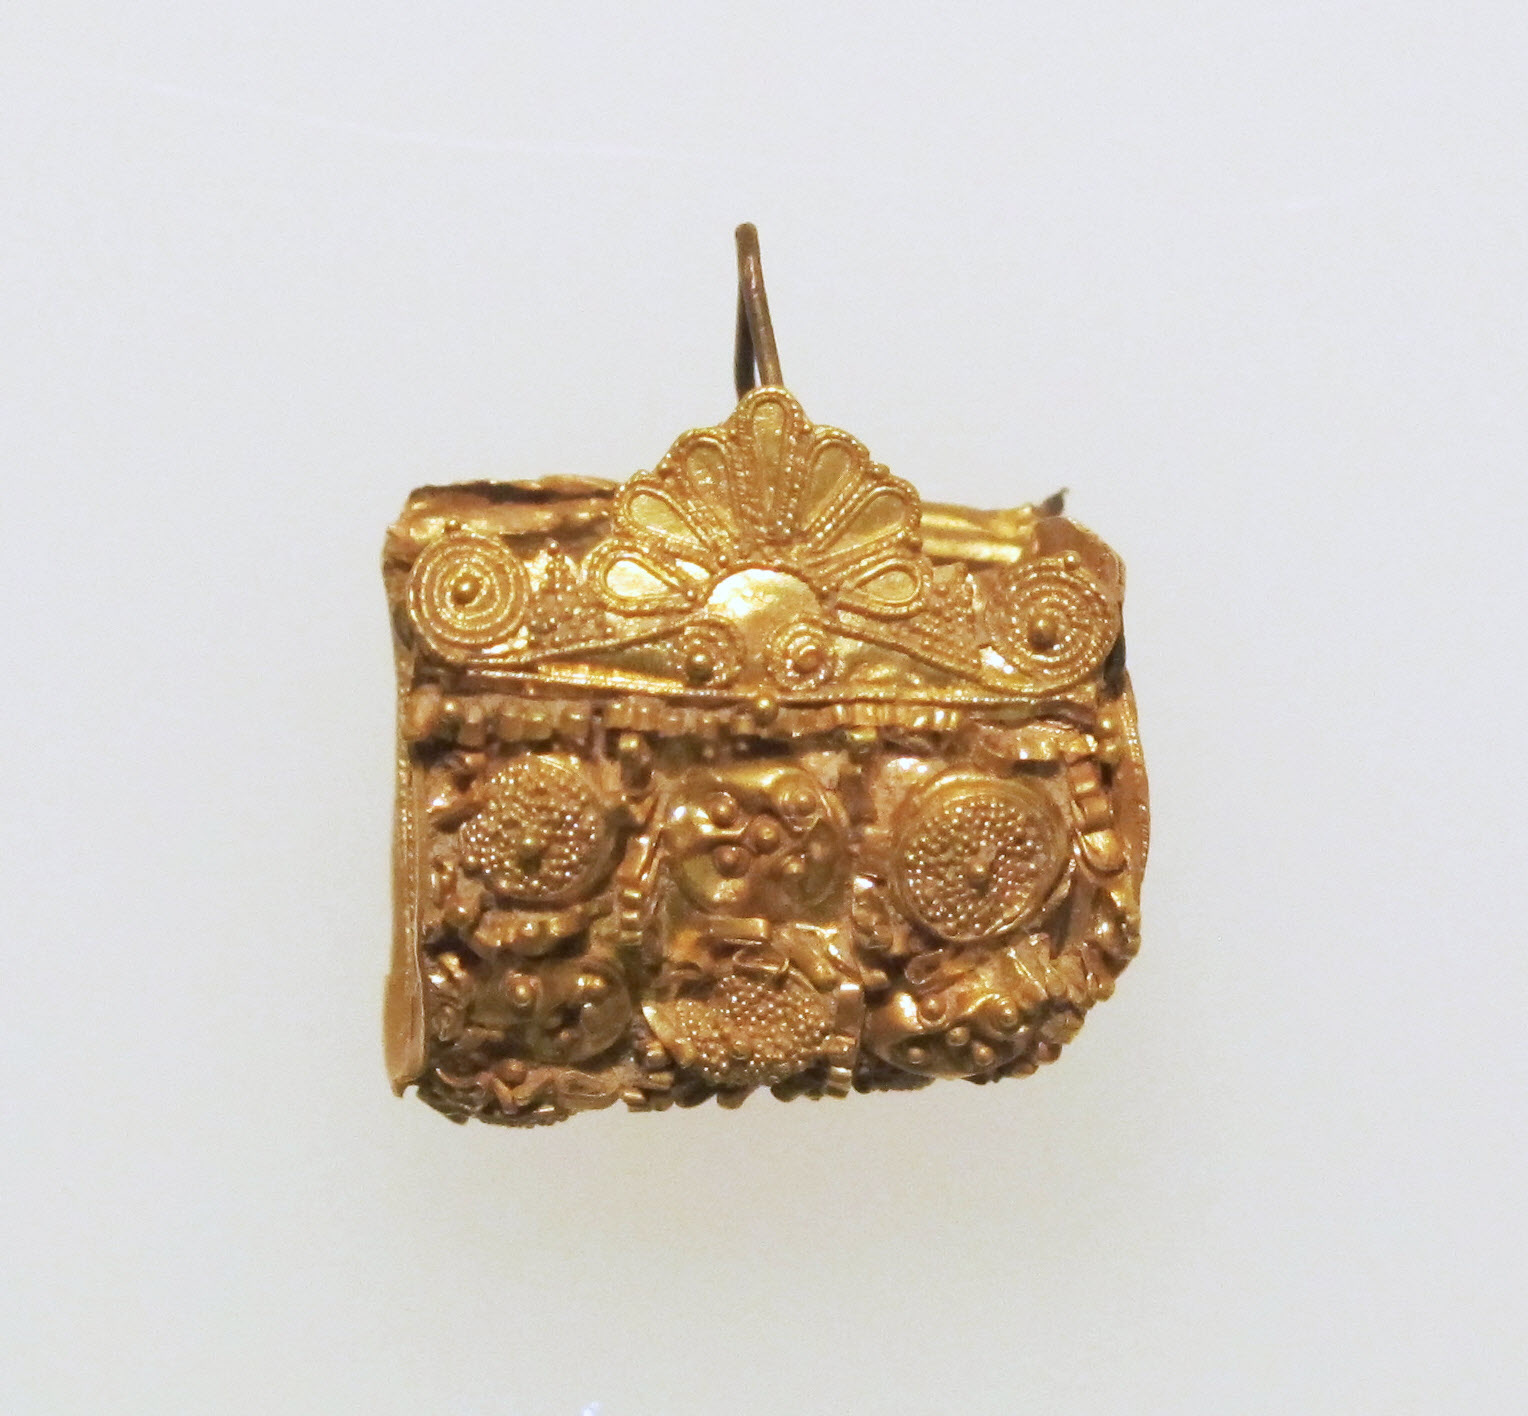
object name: earring, baule type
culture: etruscan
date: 700-401 BCE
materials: gold